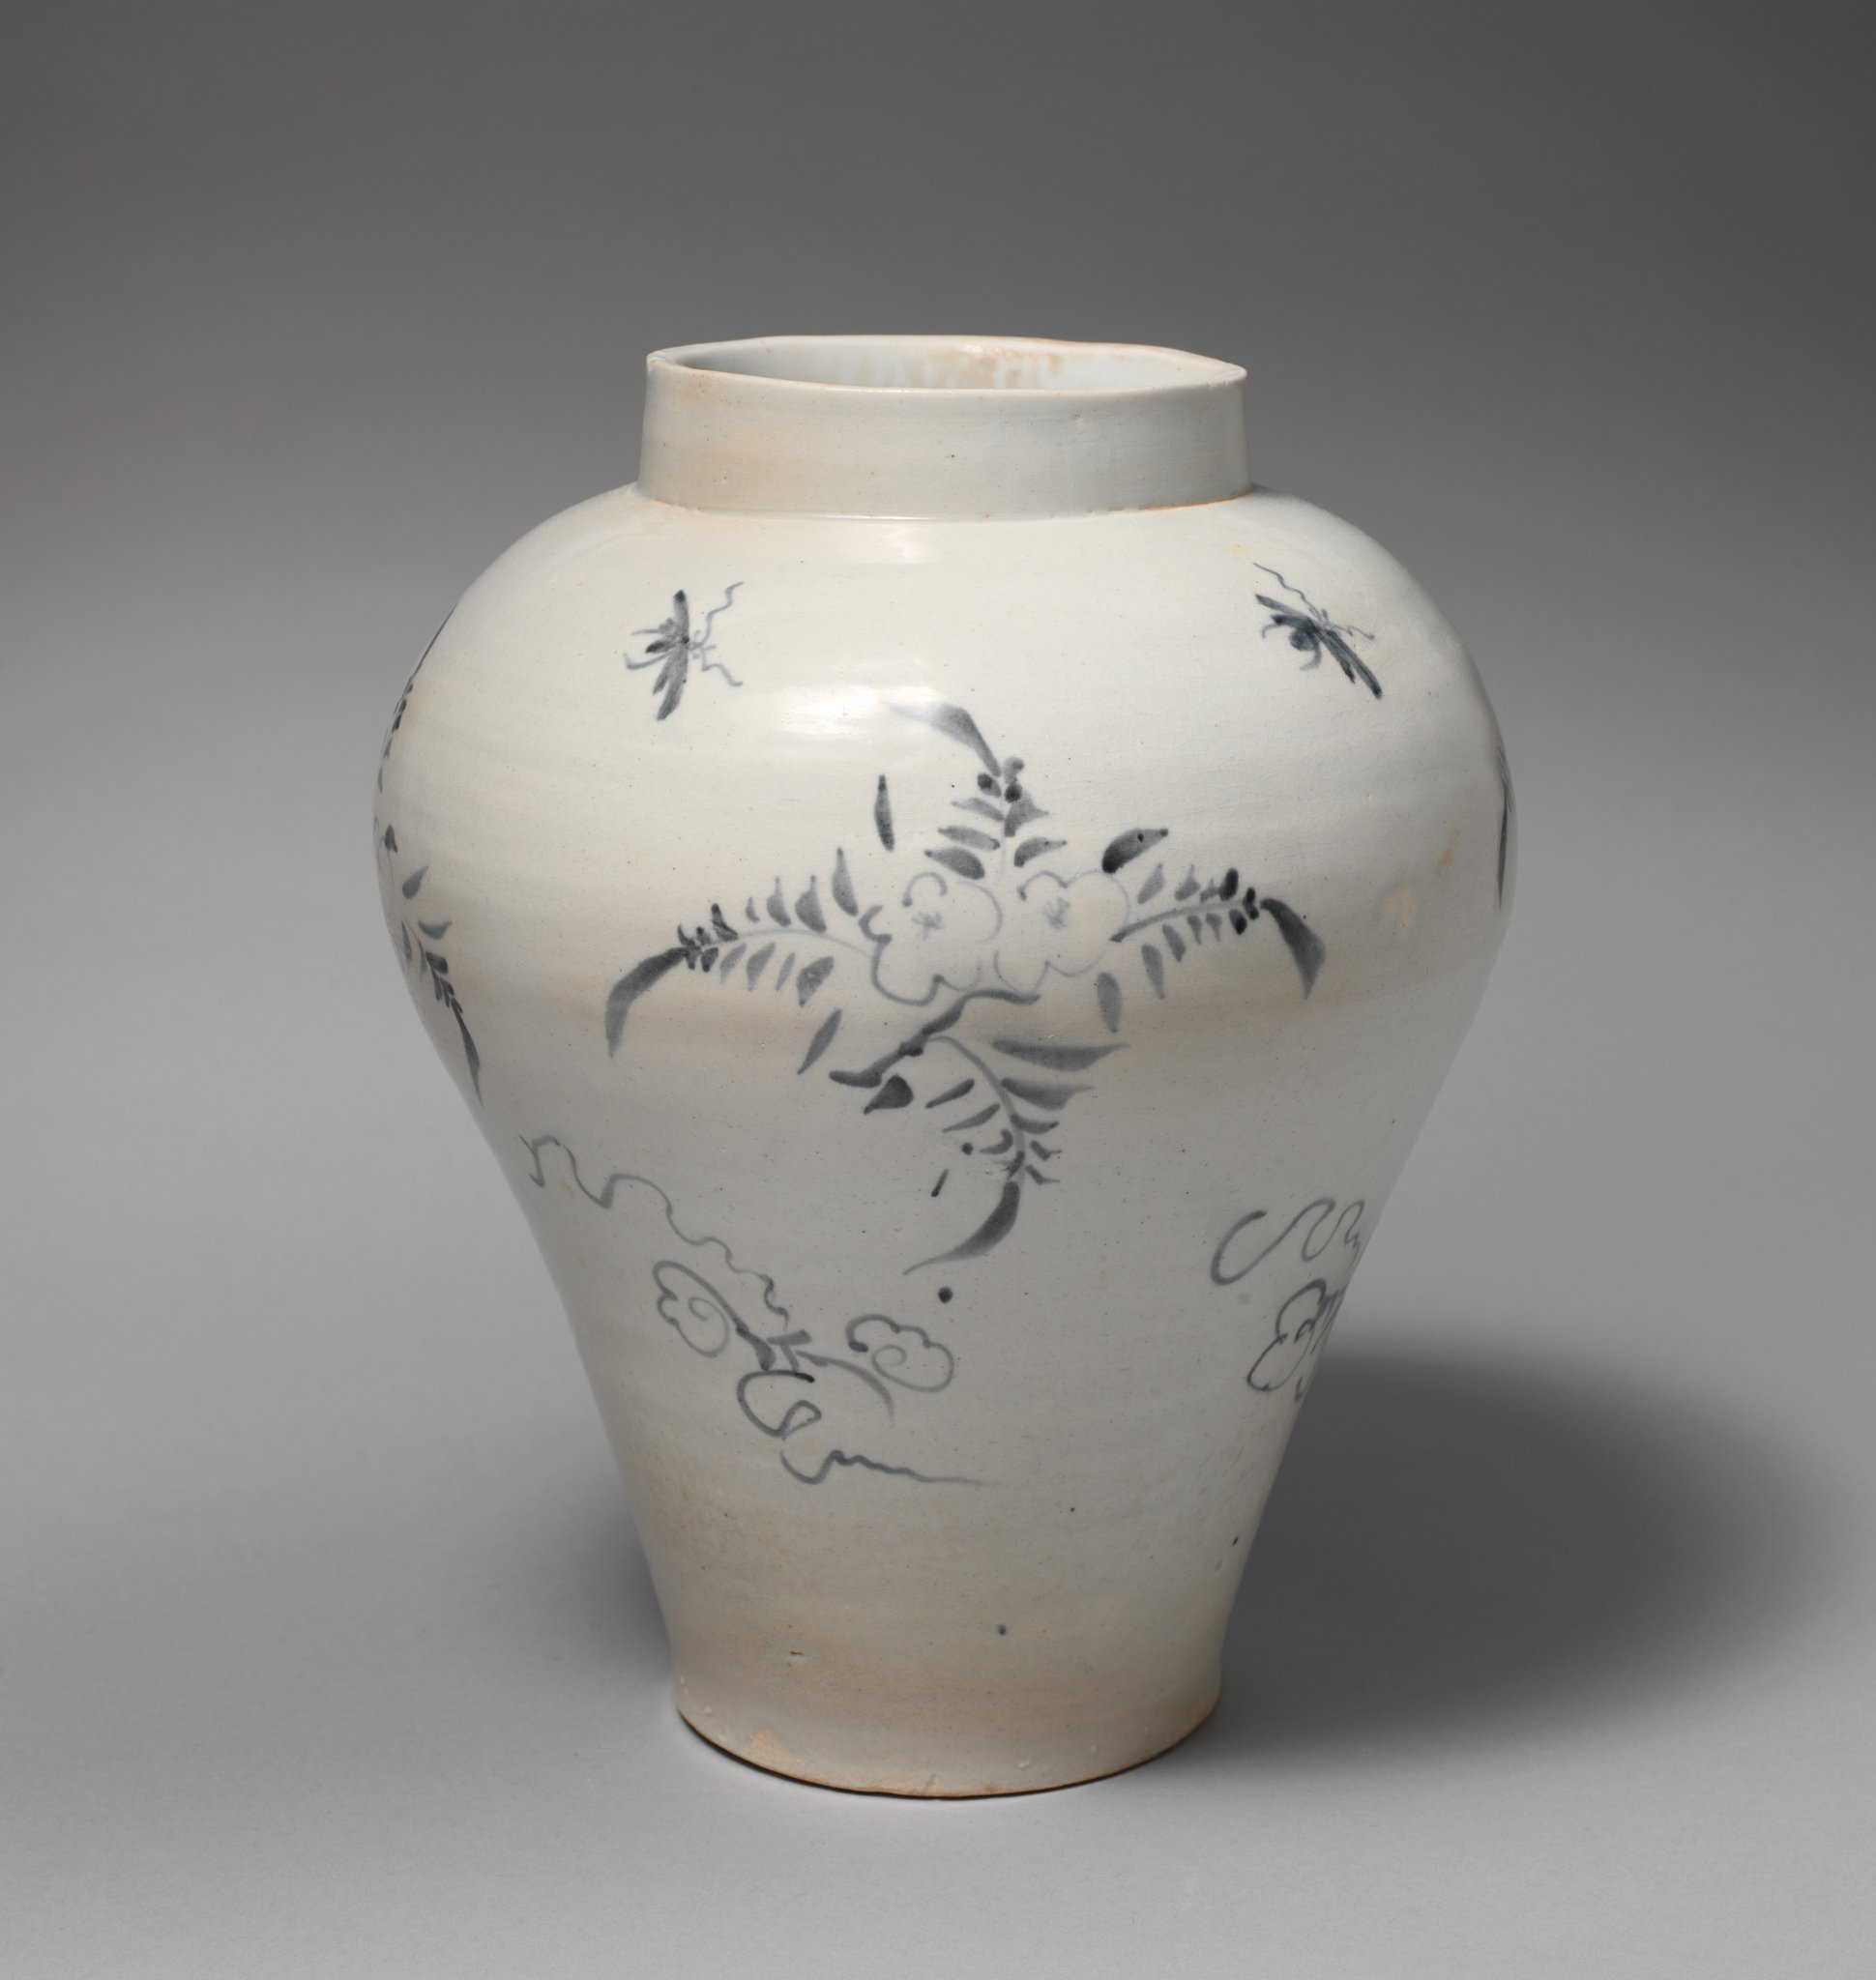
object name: jar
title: Jar decorated with flowers and insects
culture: korean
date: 1734-1766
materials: cobalt, porcelain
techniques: underglaze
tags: insects